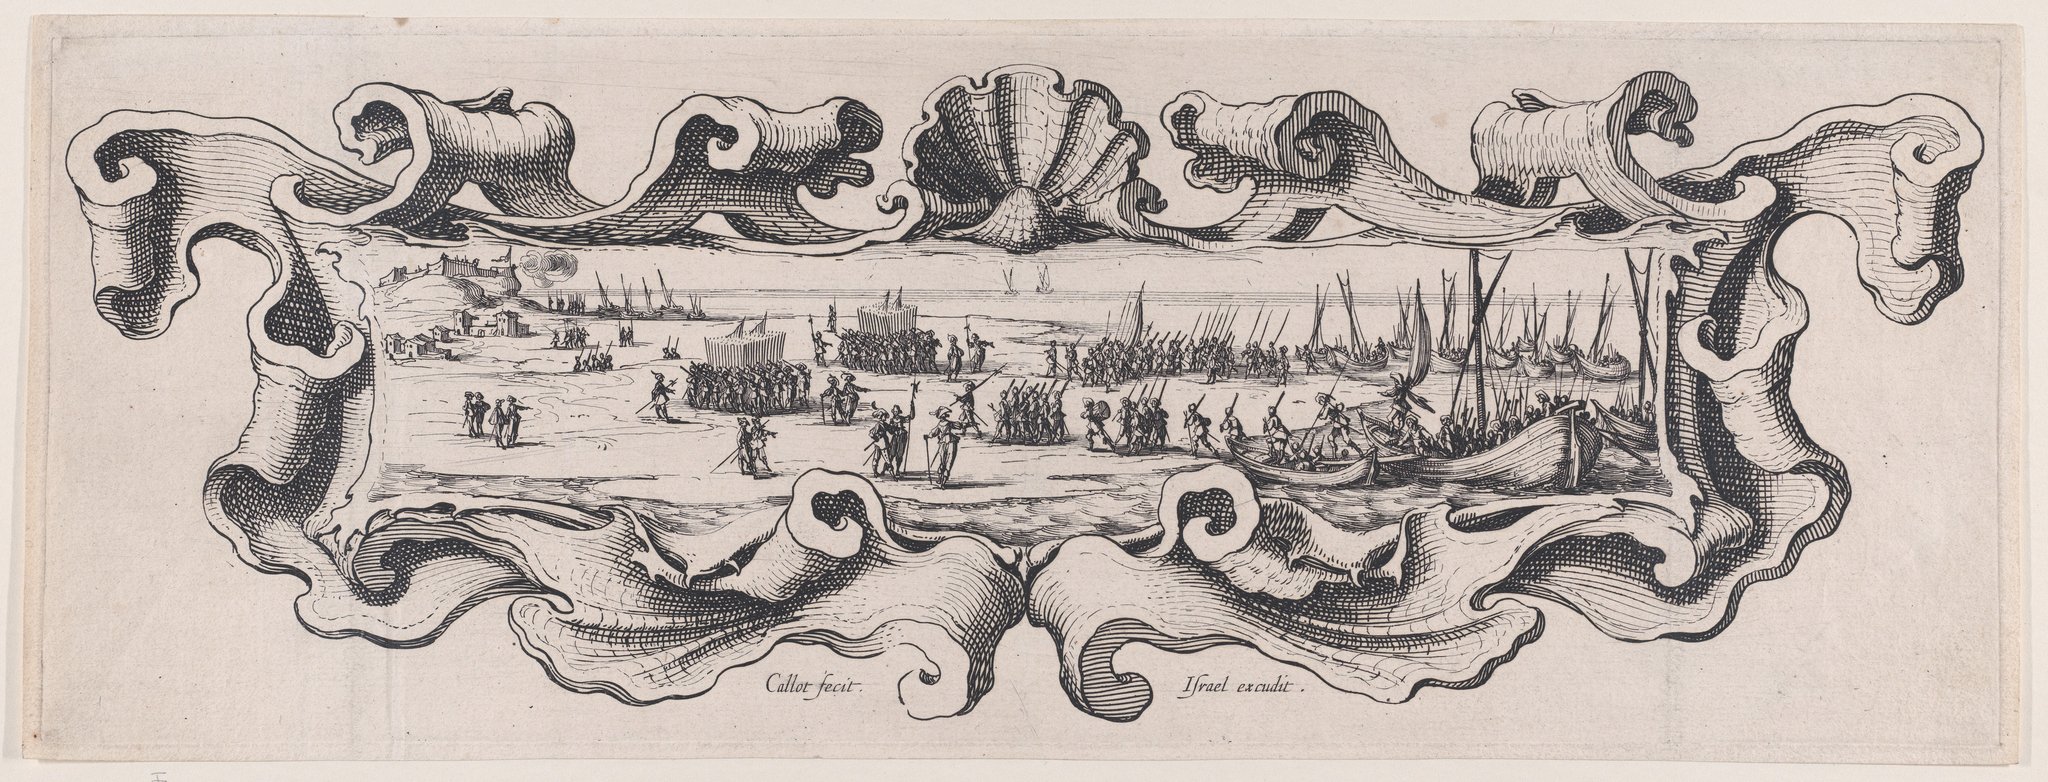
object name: print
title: Le Débarquement des Troupes (The Landing of the Troops)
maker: jacques callot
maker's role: artist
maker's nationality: french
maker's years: 1592-1635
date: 1628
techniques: engraving, etching